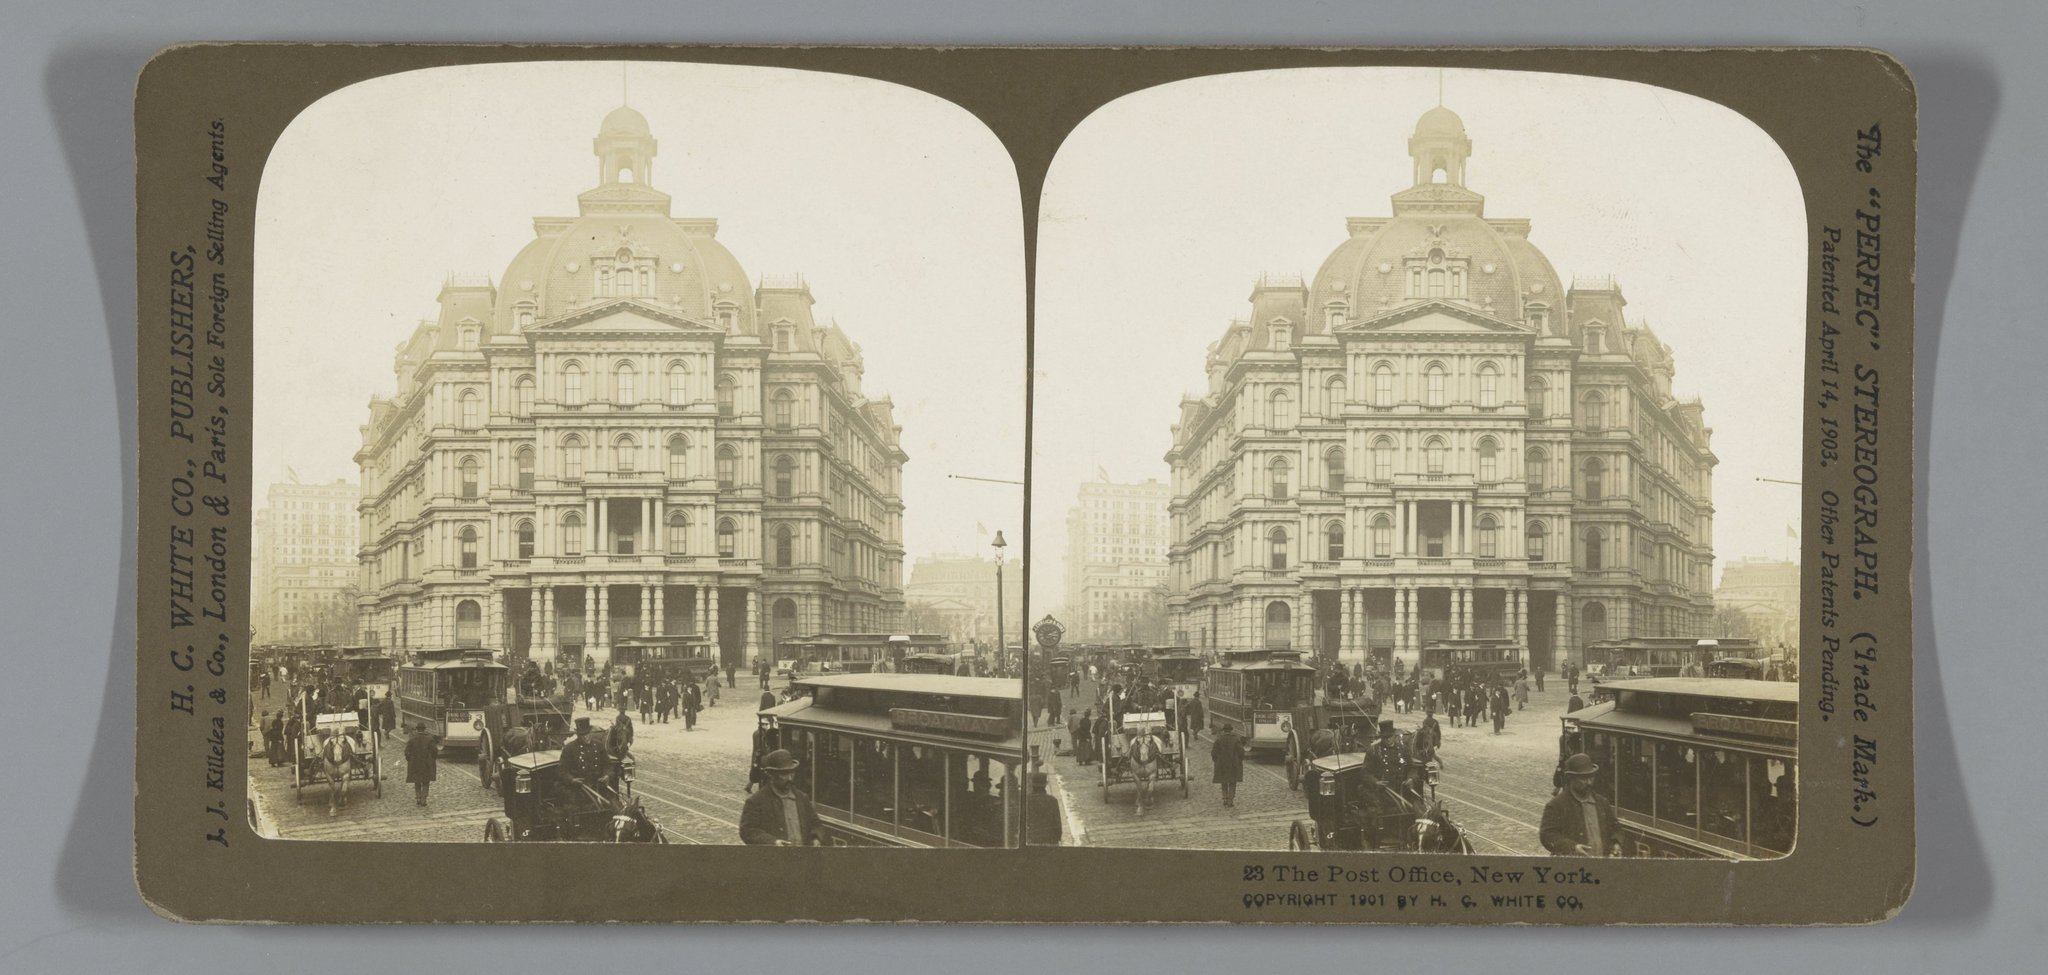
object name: stereograph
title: The Post Office, New York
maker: Anonymous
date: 1901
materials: paper, cardboard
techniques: gelatin silver print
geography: new york city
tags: city-view in general; 'veduta', new york (city)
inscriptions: inscription: ‘The " PERFEC" STEREOGRAPH. (Trade Mark.)/ Patented April 14, 1903. Other Patents Pending.’, copyright notice: ‘Copyright 1901 by H. C. White Co.’, number: ‘23’